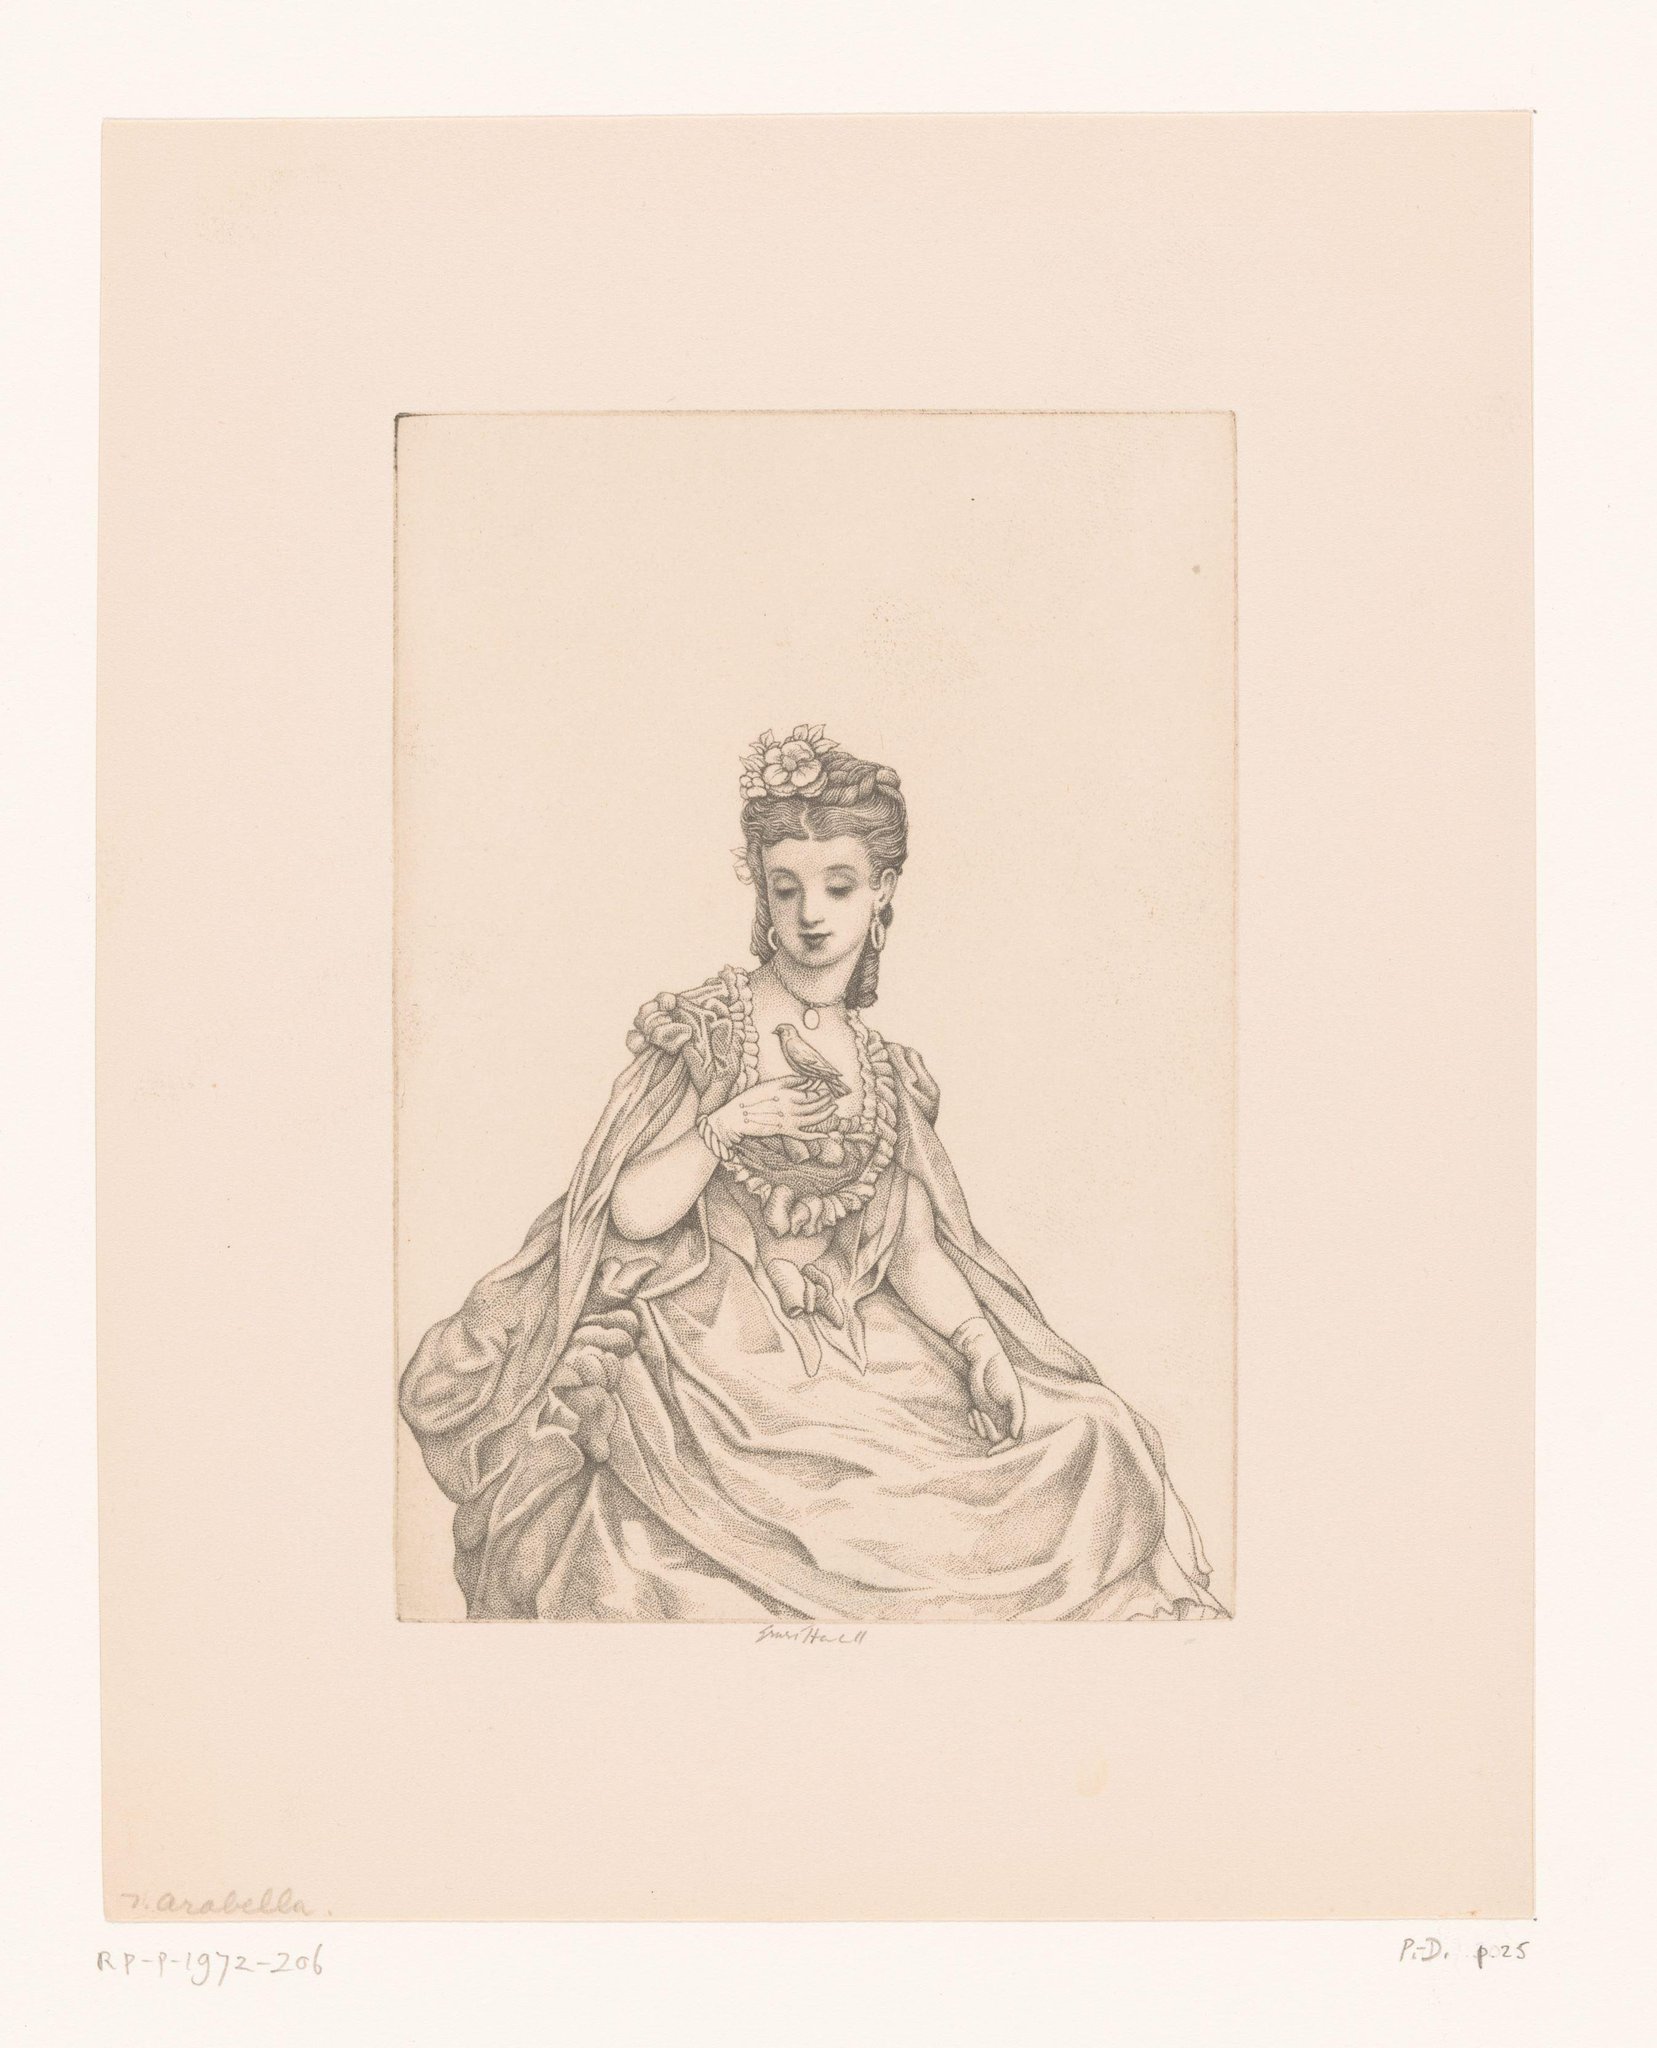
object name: print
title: Arabella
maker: ernest haskell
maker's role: draughtsman, print maker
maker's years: 1876-1925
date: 1915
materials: paper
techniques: engraving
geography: united states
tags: sitting figure, adult woman, historical persons not known by name - bb - woman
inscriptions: signature: ‘Ernest Haskell’, collector's mark: Lugt 2228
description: Zittende jonge vrouw 'Arabella' met vogeltje op de hand.